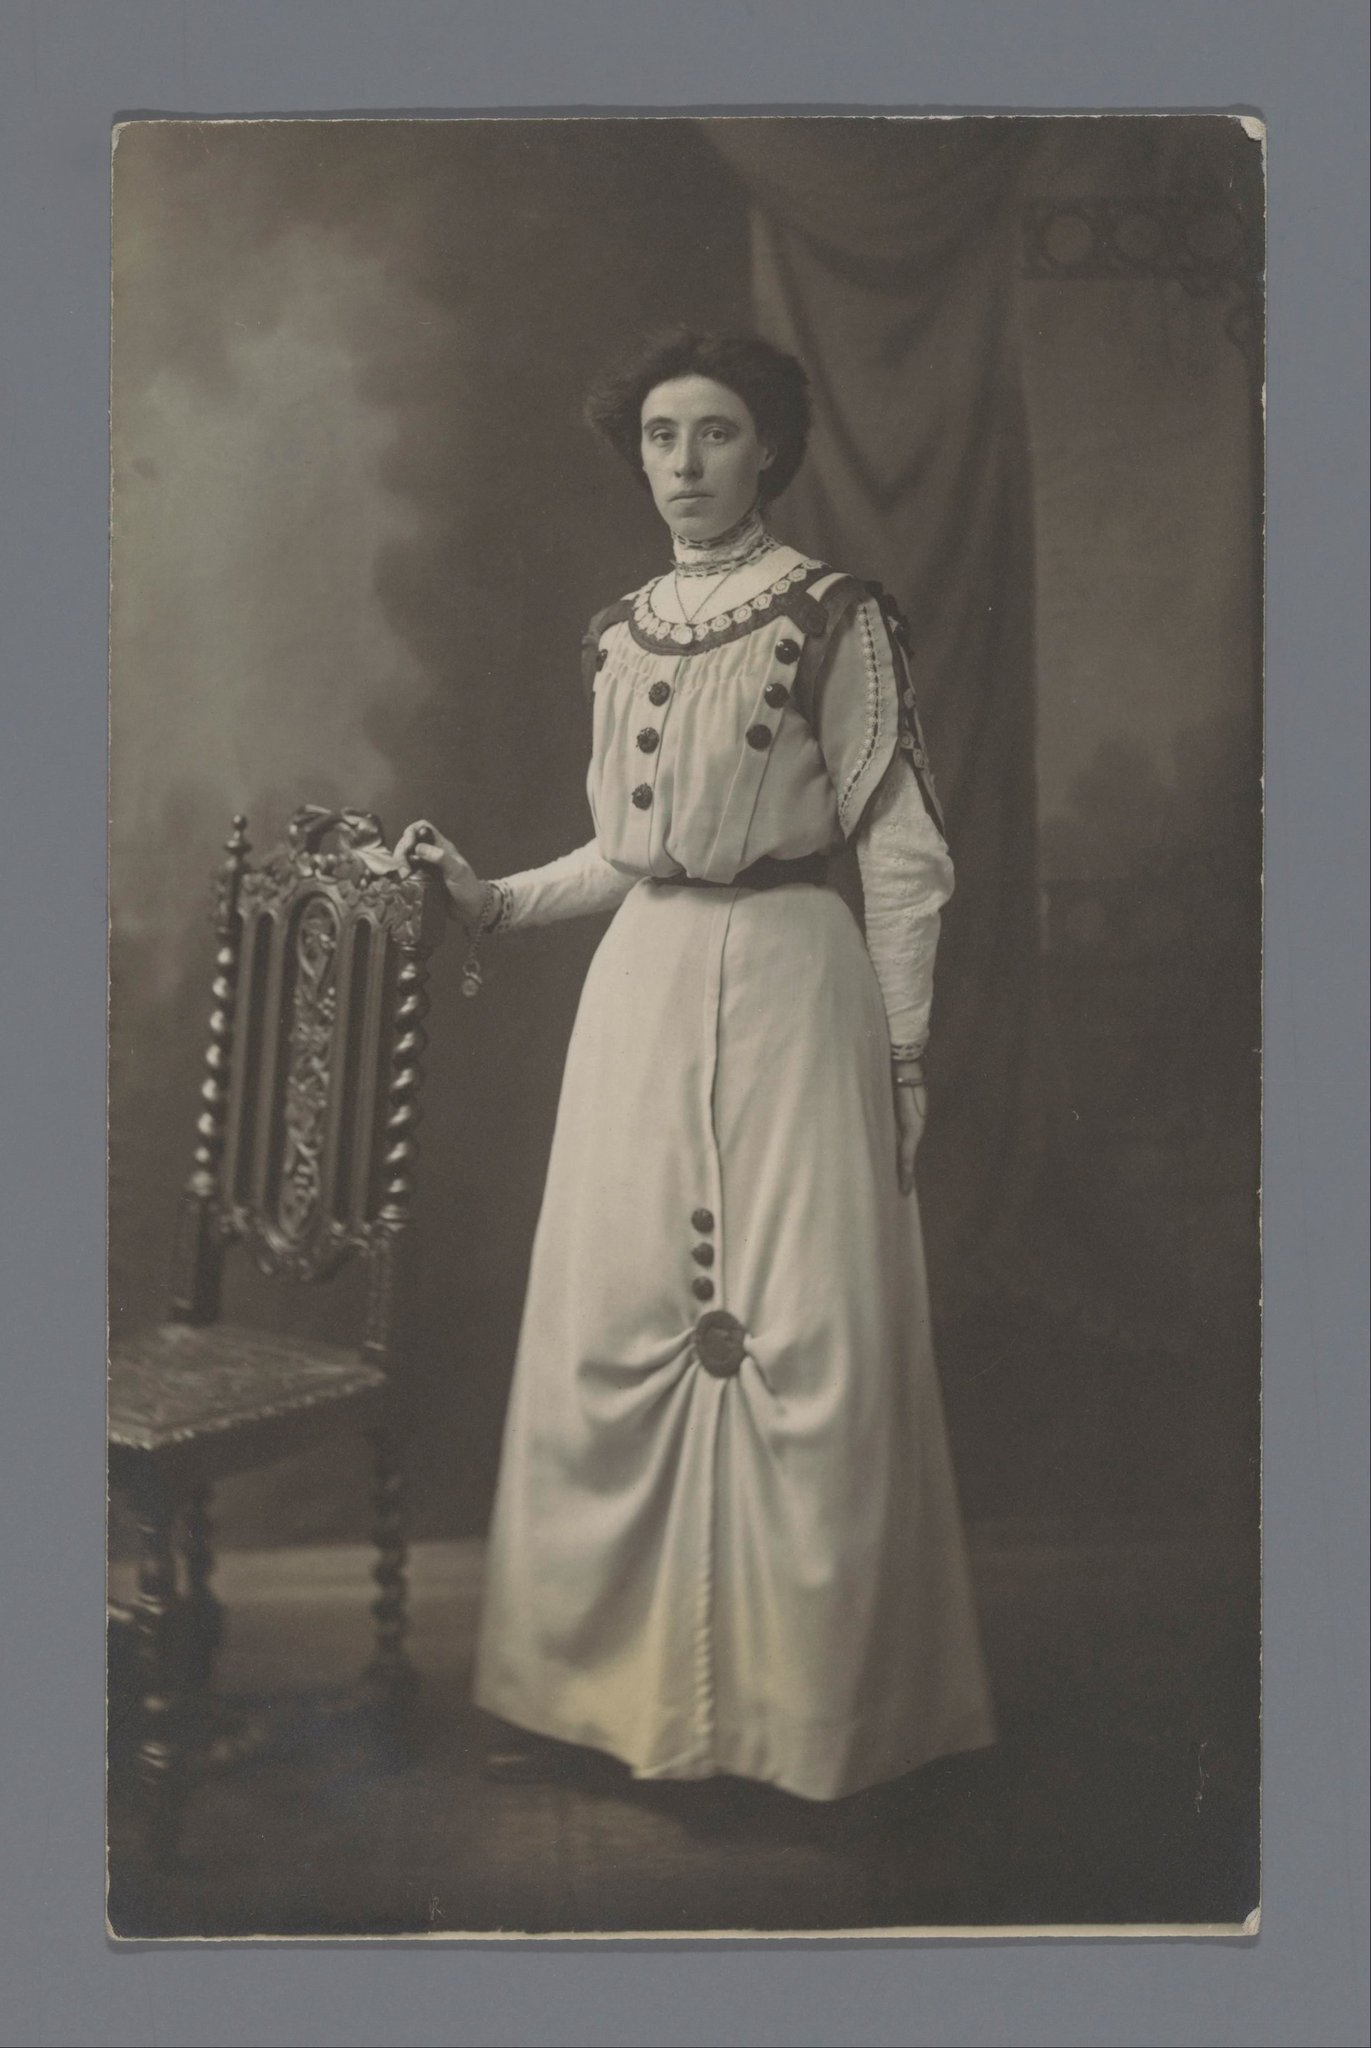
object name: ansichtkaart, prentbriefkaart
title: Studioportret van een onbekende vrouw naast een stoel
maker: Anonymous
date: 1907-1920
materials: photographic support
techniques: gelatin silver print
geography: great britain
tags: studio ~ photographer, adult woman, chair